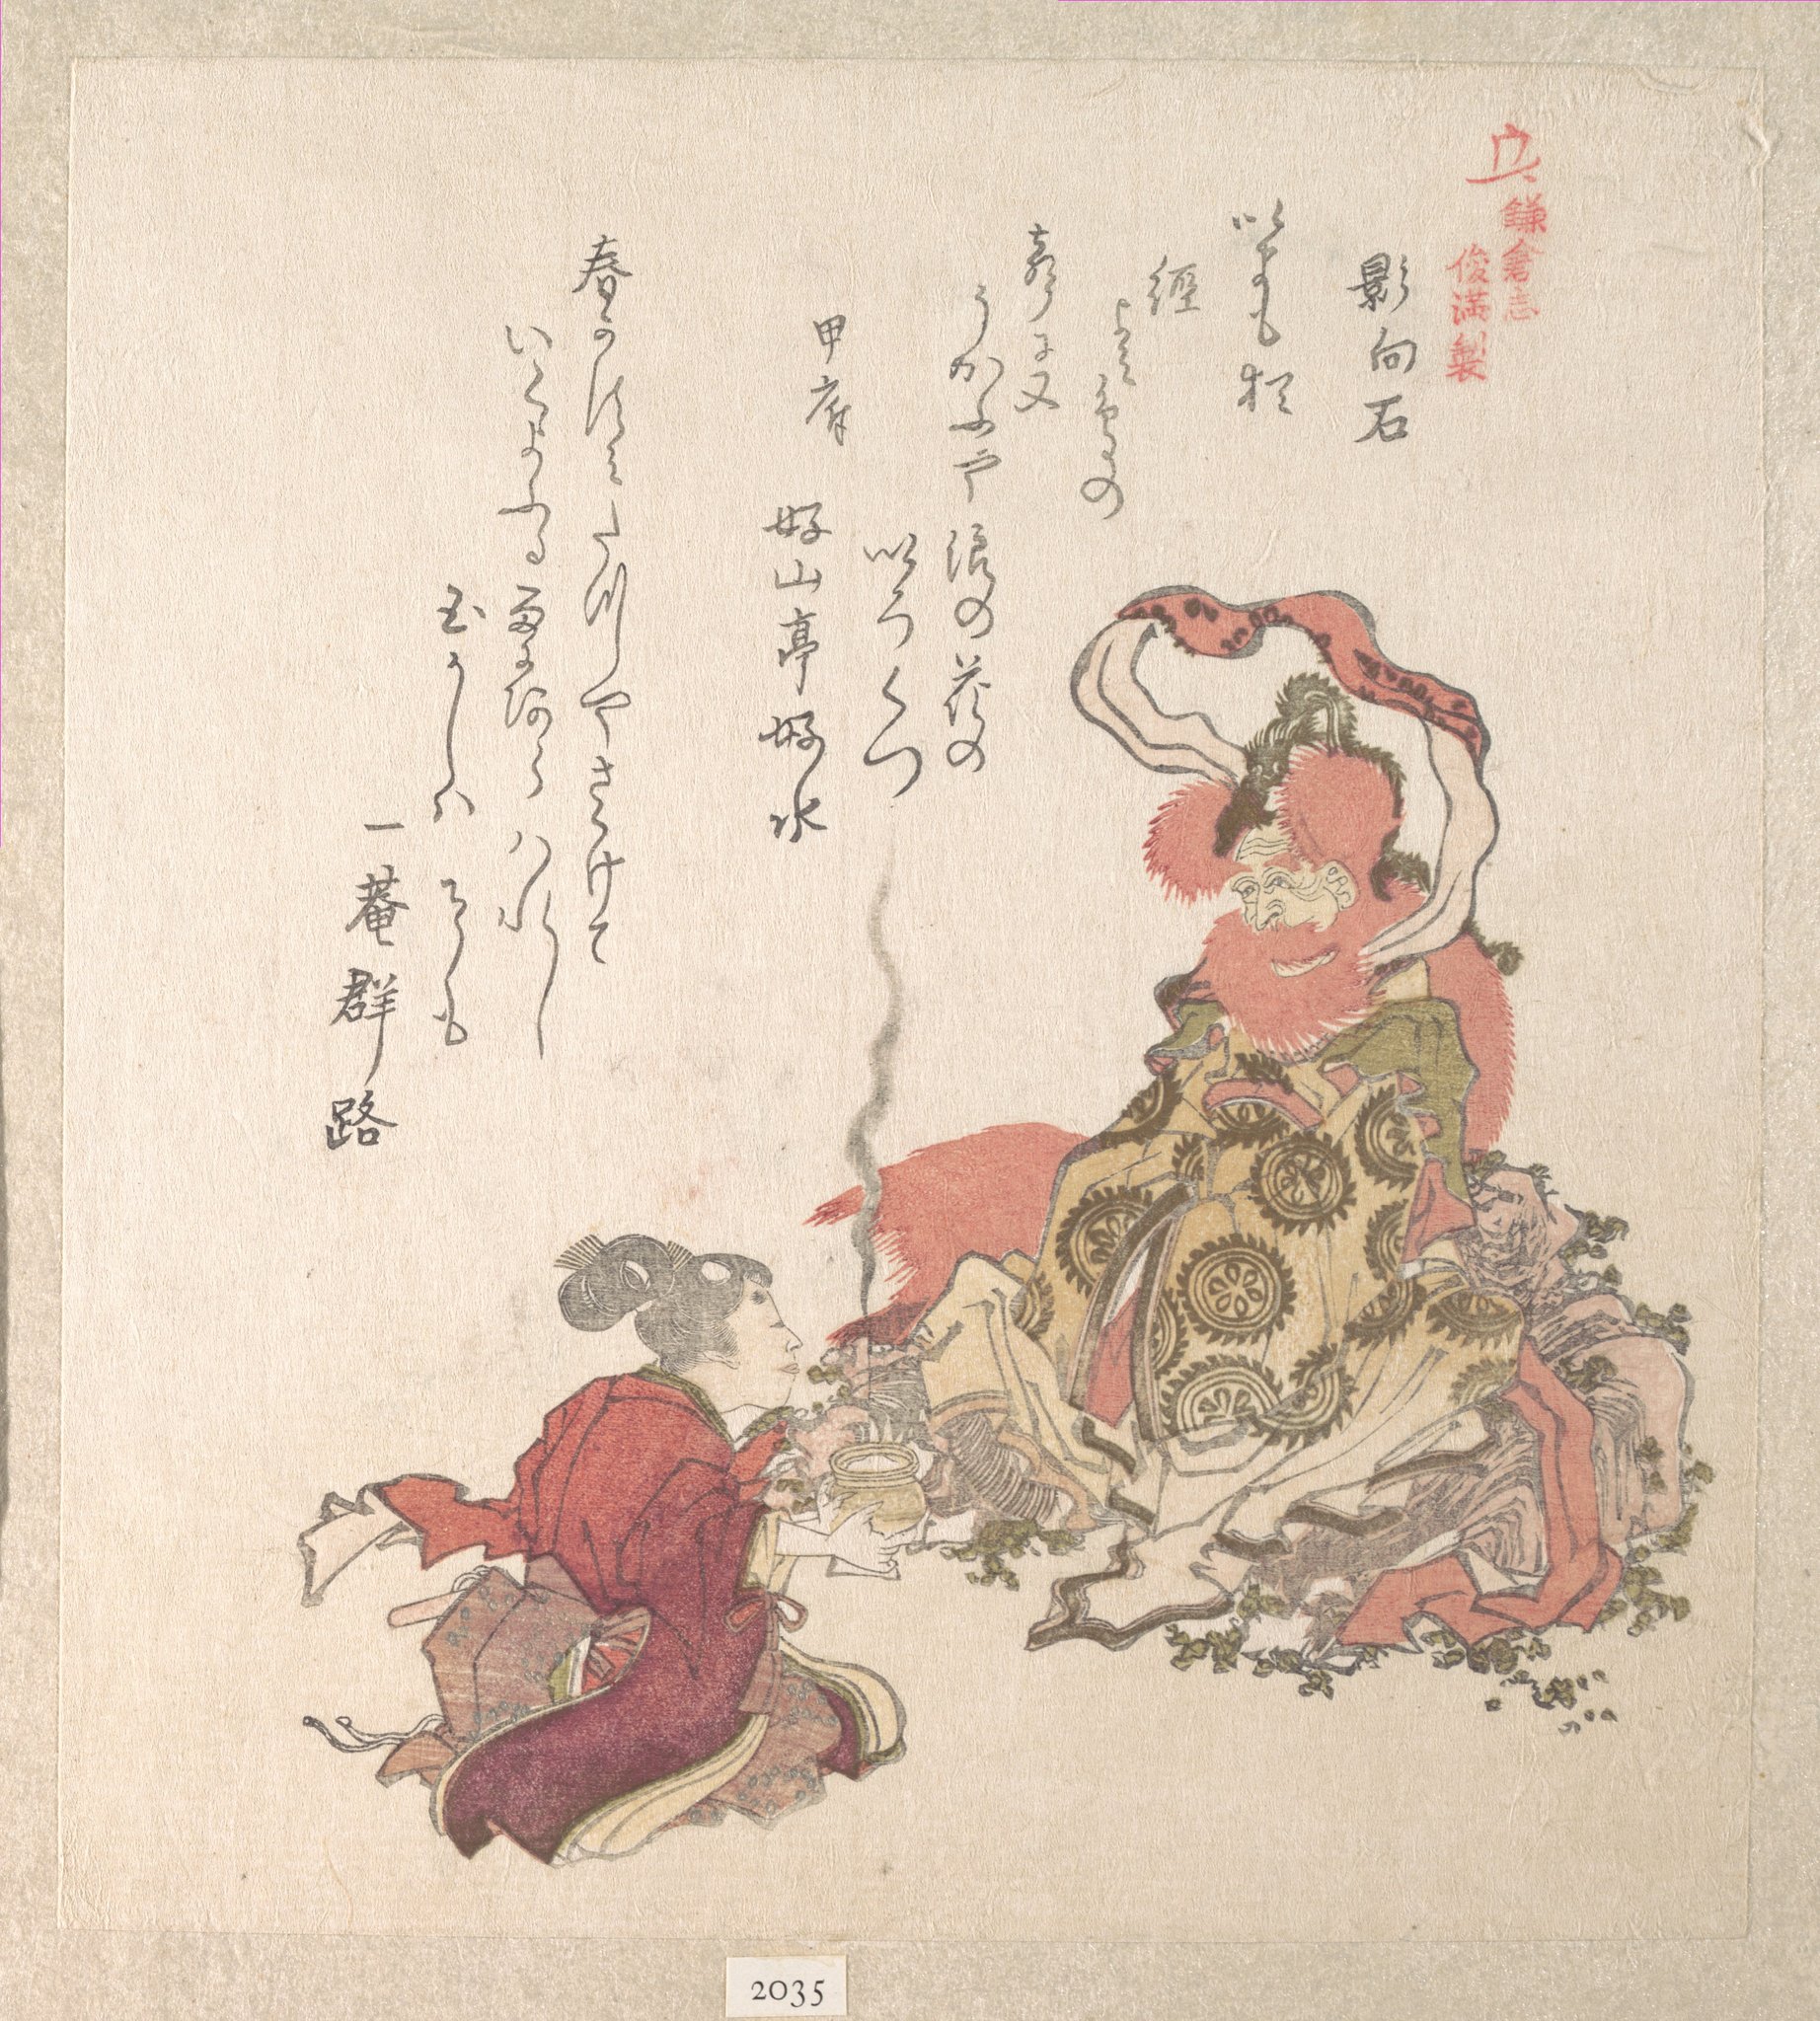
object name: print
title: Spring Rain Collection (Harusame shū), vol. 1: “Offering Incense to the Deity of the Stone” (Yōgōishi), from the series History of Kamakura (Kamakura shi)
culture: japanese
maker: kubo shunman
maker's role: artist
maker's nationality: japanese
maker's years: 1757-1820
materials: ink, paper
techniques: surimono, woodblock print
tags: men,women